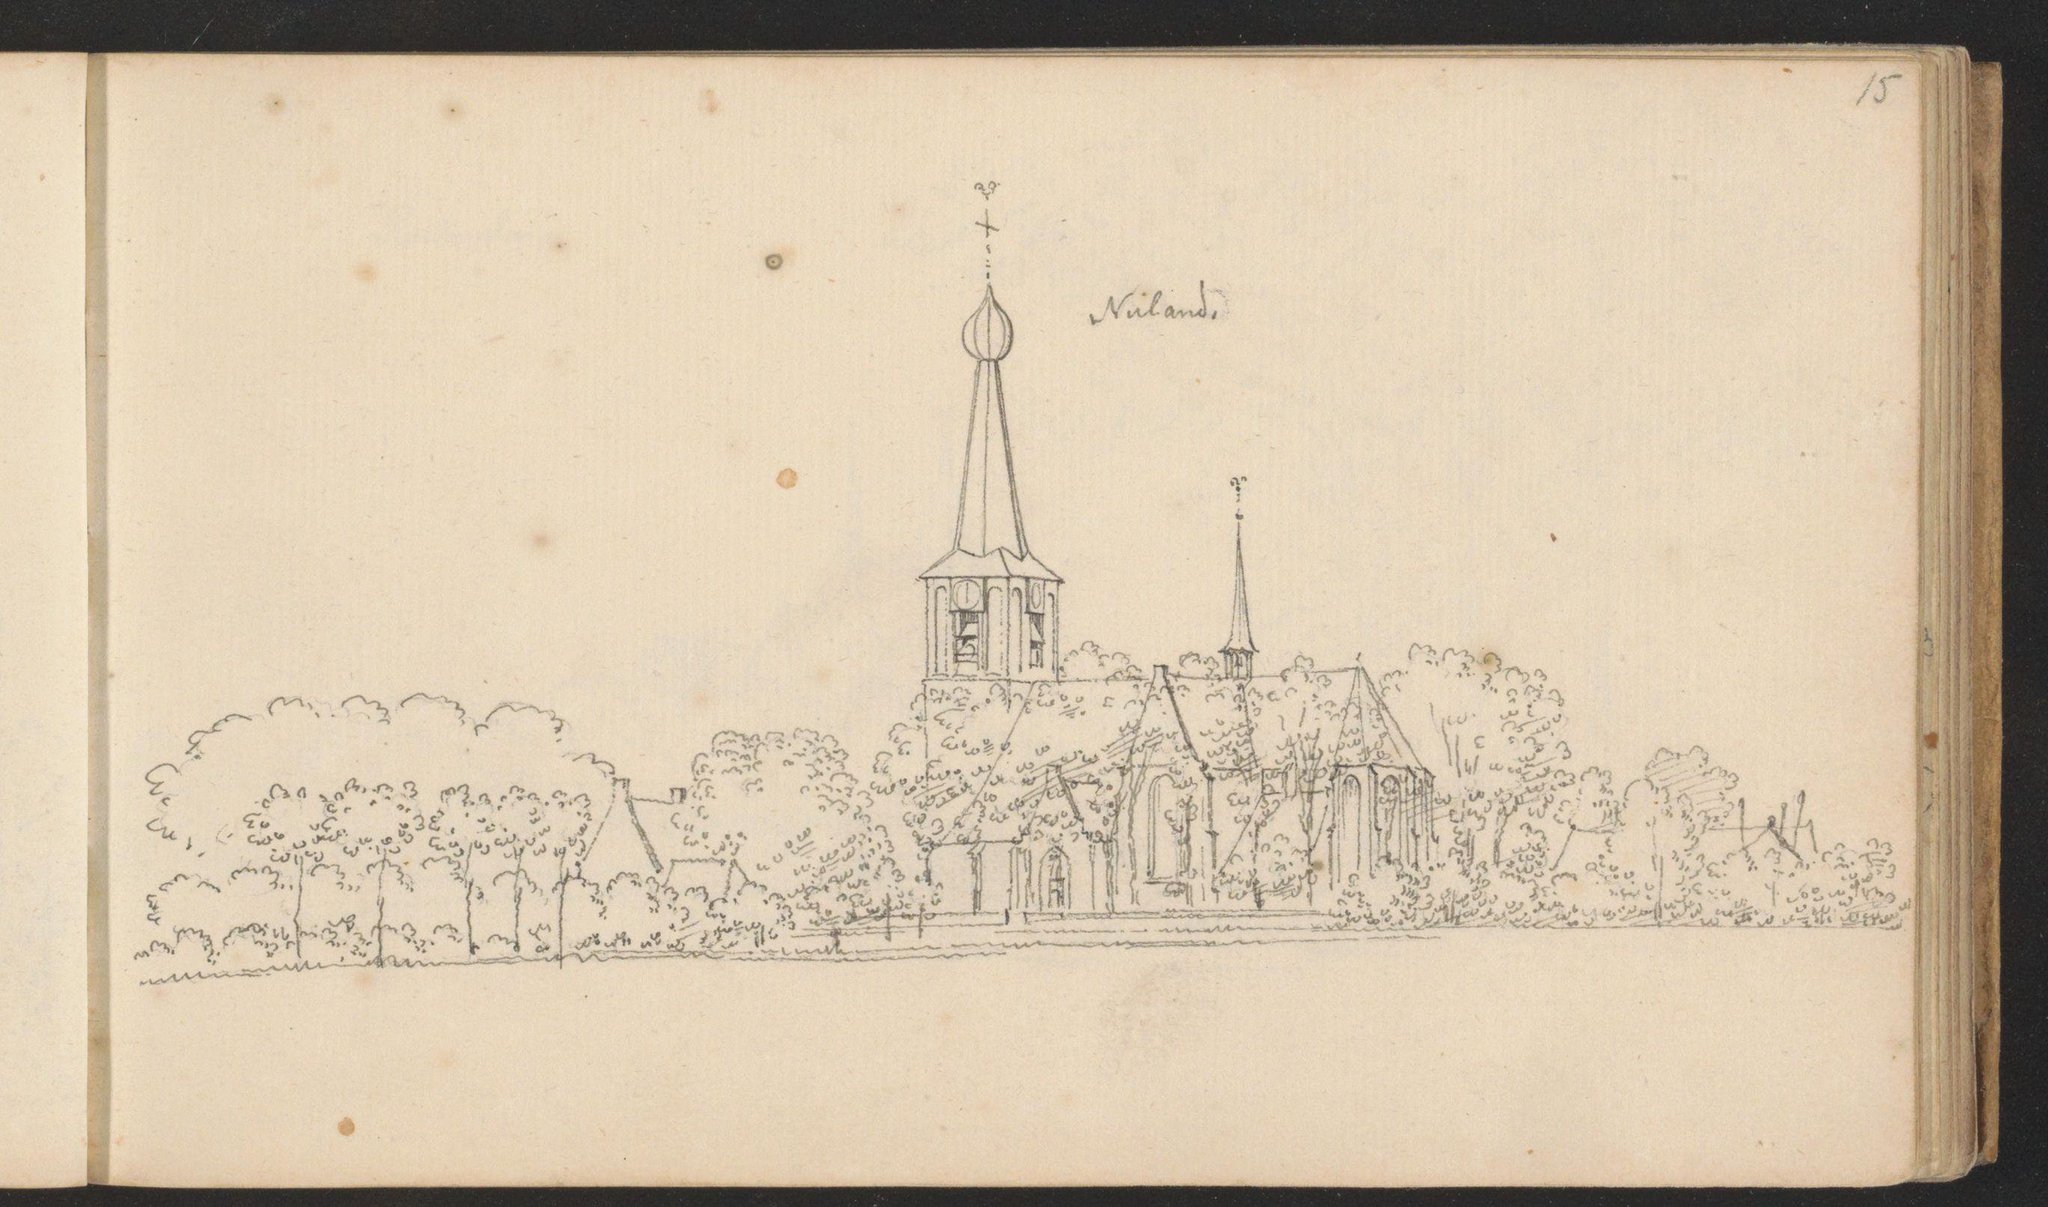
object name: sketchbook leaf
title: Gezicht op Nuland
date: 1701-1759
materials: ink, paper, pencil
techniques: brush, pen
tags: prospect of village, silhouette of village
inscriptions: annotation: ‘Nuland’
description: Blad 15 recto uit een schetsboek met 65 bladen.